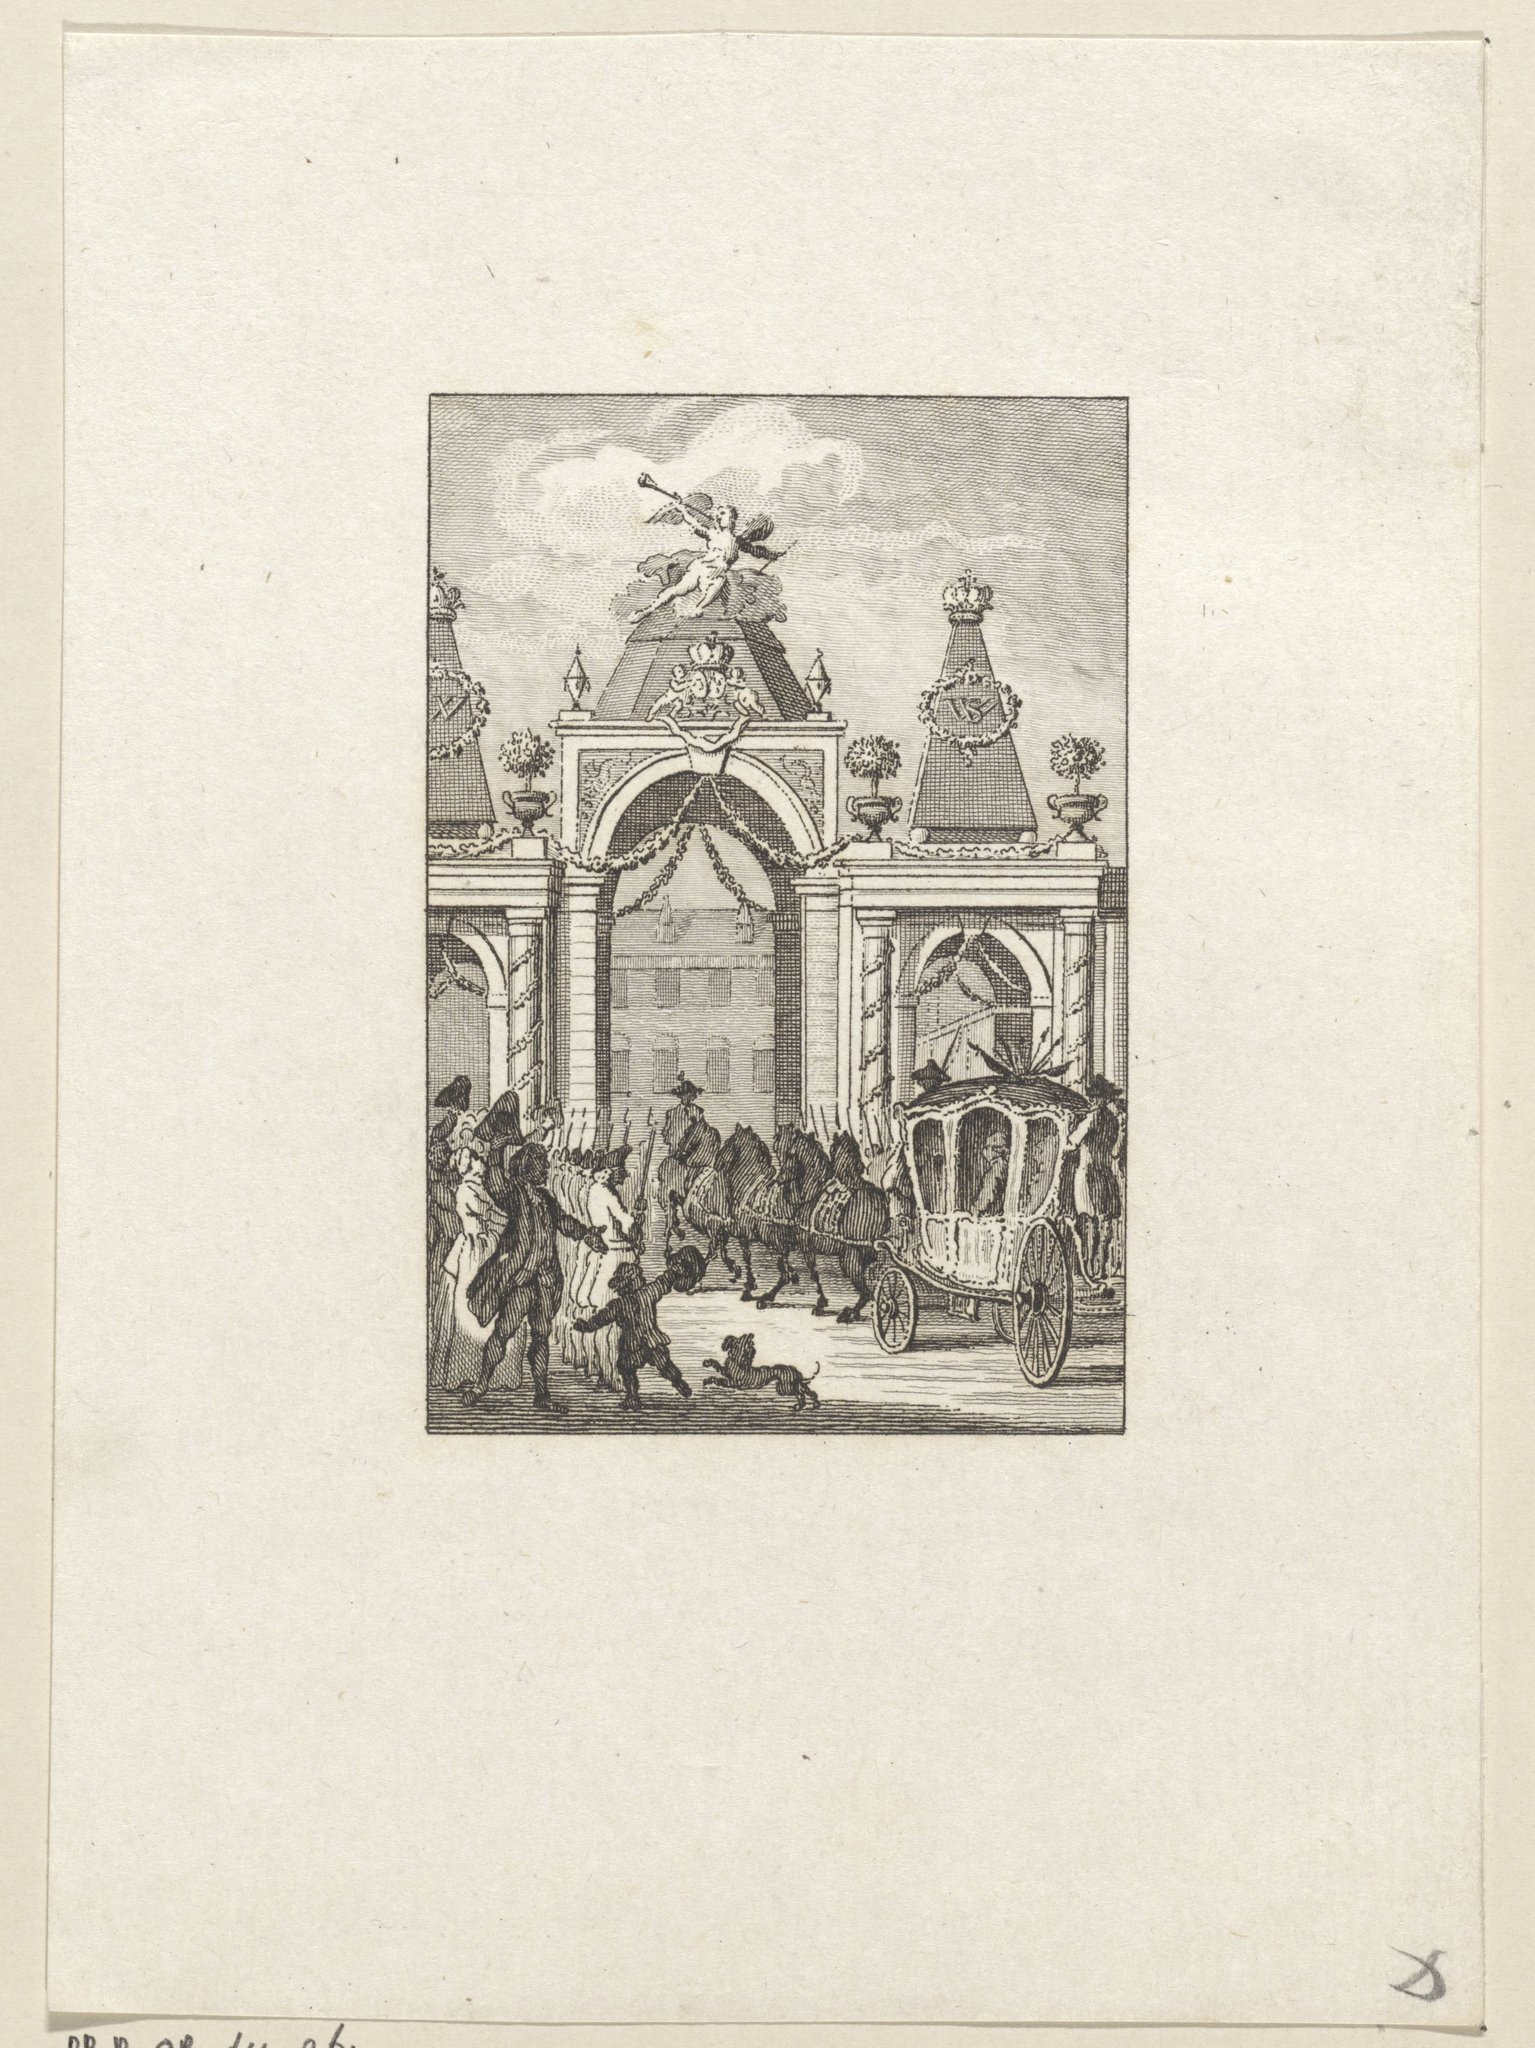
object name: history print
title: Intocht in Den Haag van Willem V en Wilhelmina van Pruisen, 1767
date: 1783-1795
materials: paper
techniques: etching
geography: amsterdam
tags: triumphal arch (+ wreath, garland ~ festive activities), four-wheeled, animal-drawn vehicle, e.g.: cab, carriage, coach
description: Illustratie voor: J. Fokke. Geschiedenissen der Vereenigde Nederlanden voor de vaderlandsche jeugd. Amsterdam: Johannes Allart, 1783-1795, 25 delen. deel XII pl. XII.